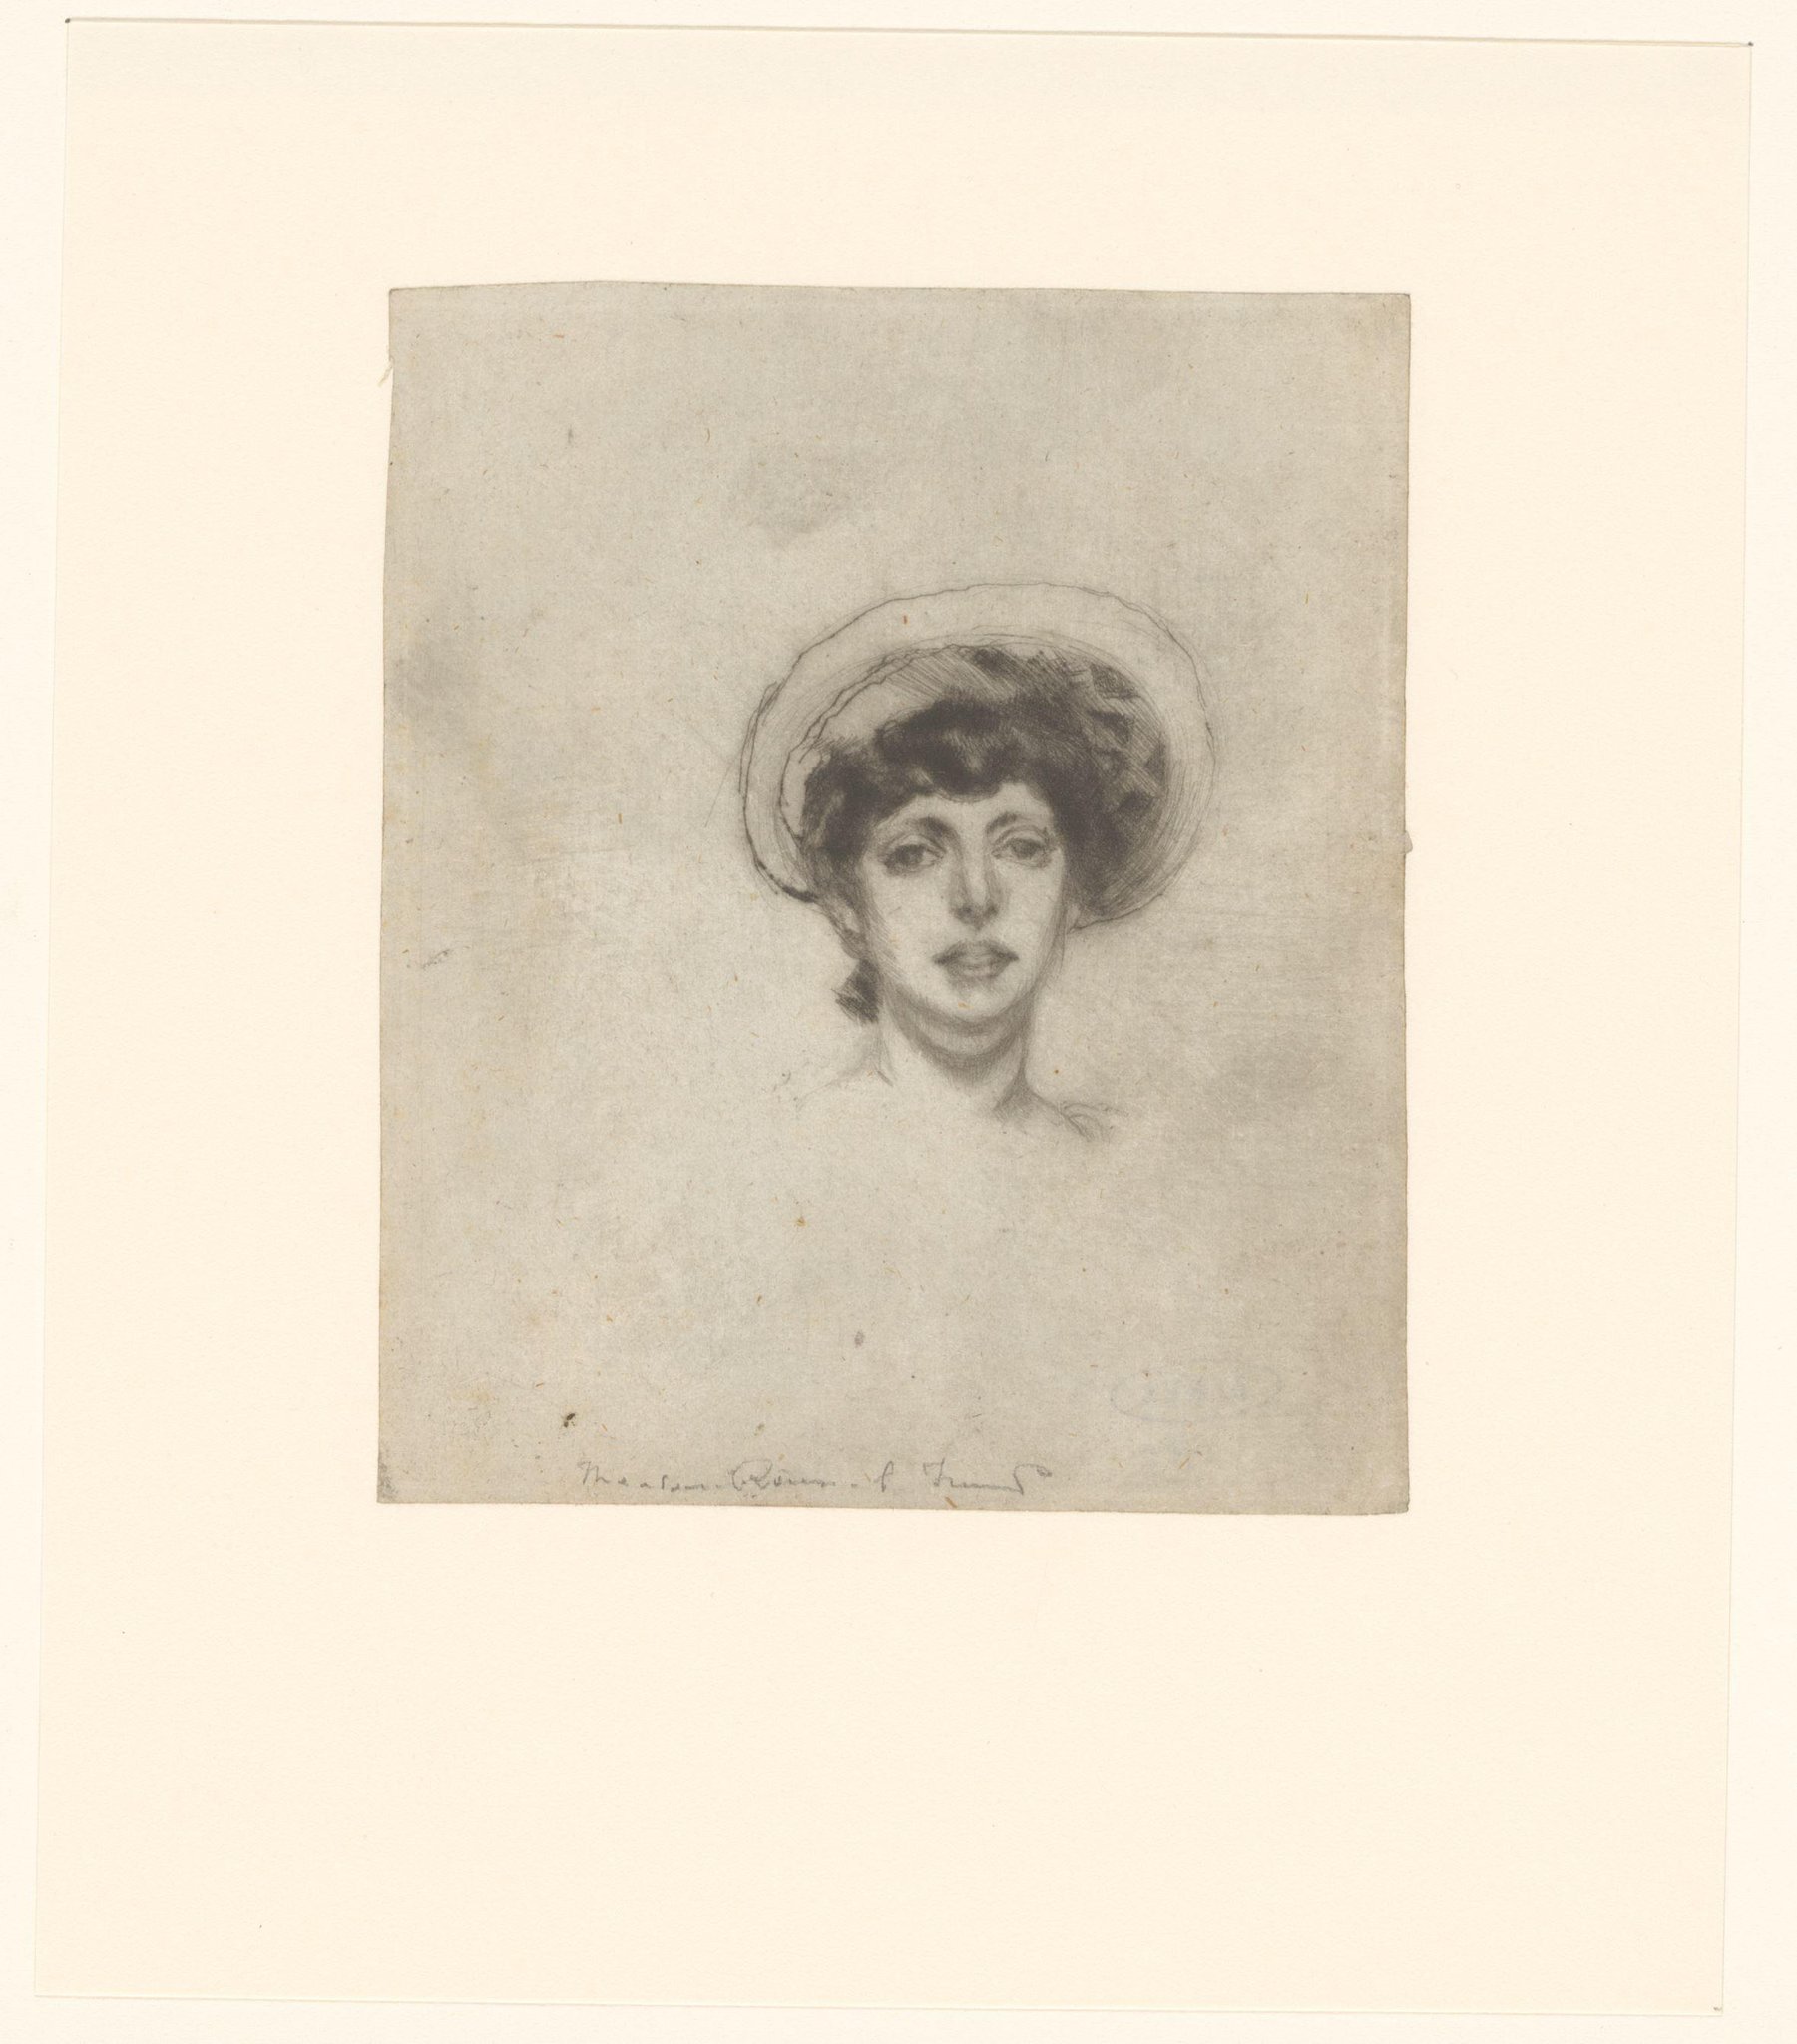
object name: print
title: Portret van miss Hetty Pettigrew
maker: théodore roussel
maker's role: print maker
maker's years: 1847-1926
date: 1908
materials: paper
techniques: drypoint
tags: london, adult woman, historical persons - bb - woman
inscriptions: collector's mark: Lugt 2228